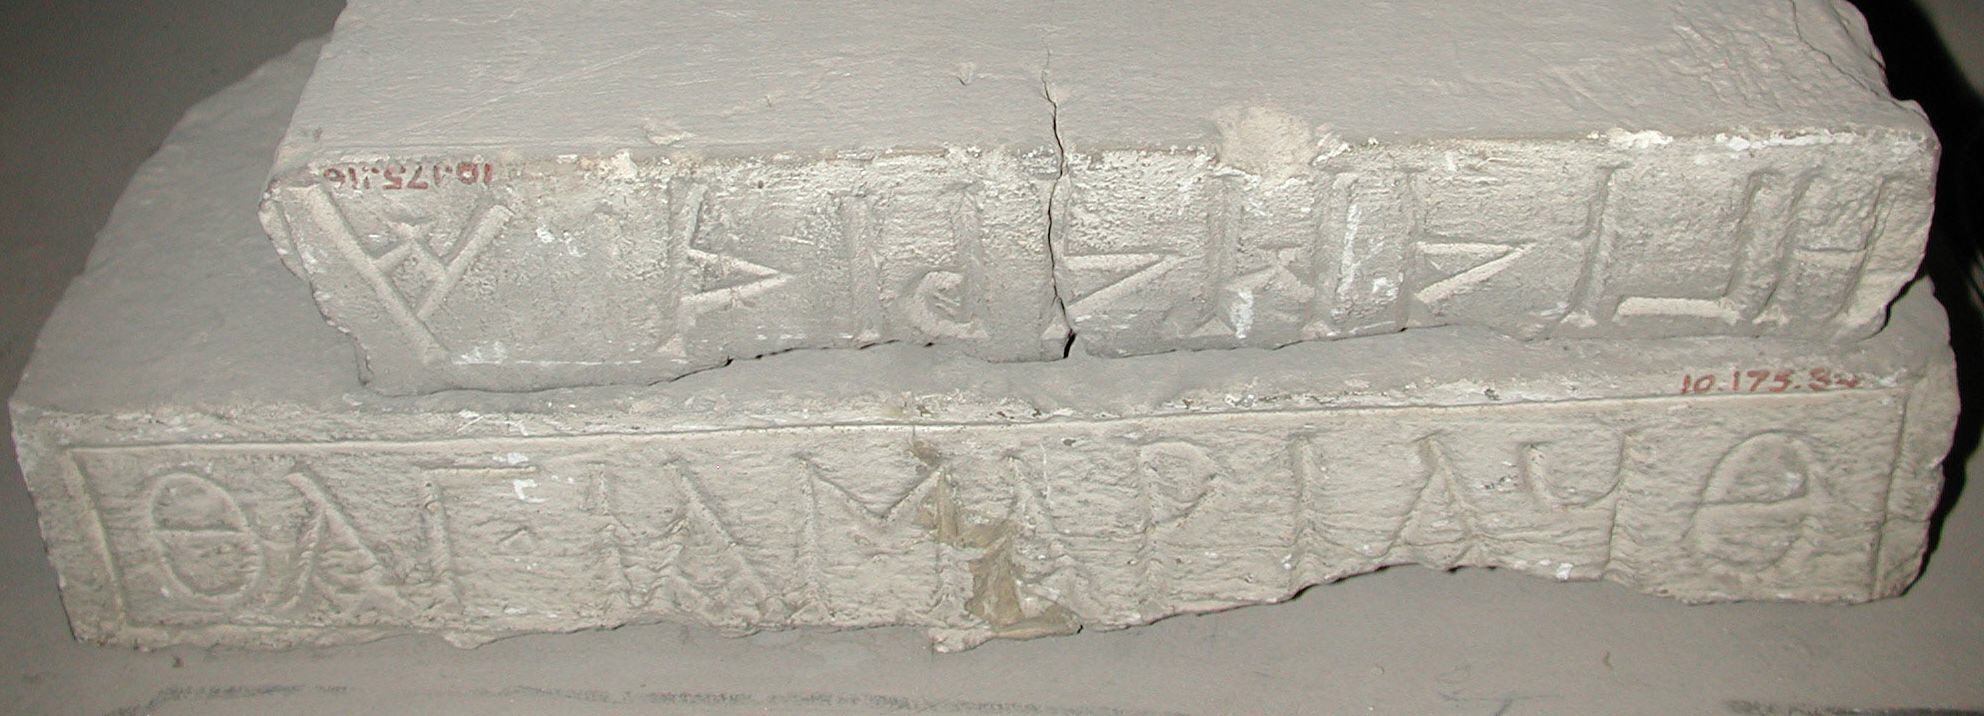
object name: fragment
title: Fragment of an Inscribed Slab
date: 501-700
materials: limestone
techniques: incising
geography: egypt